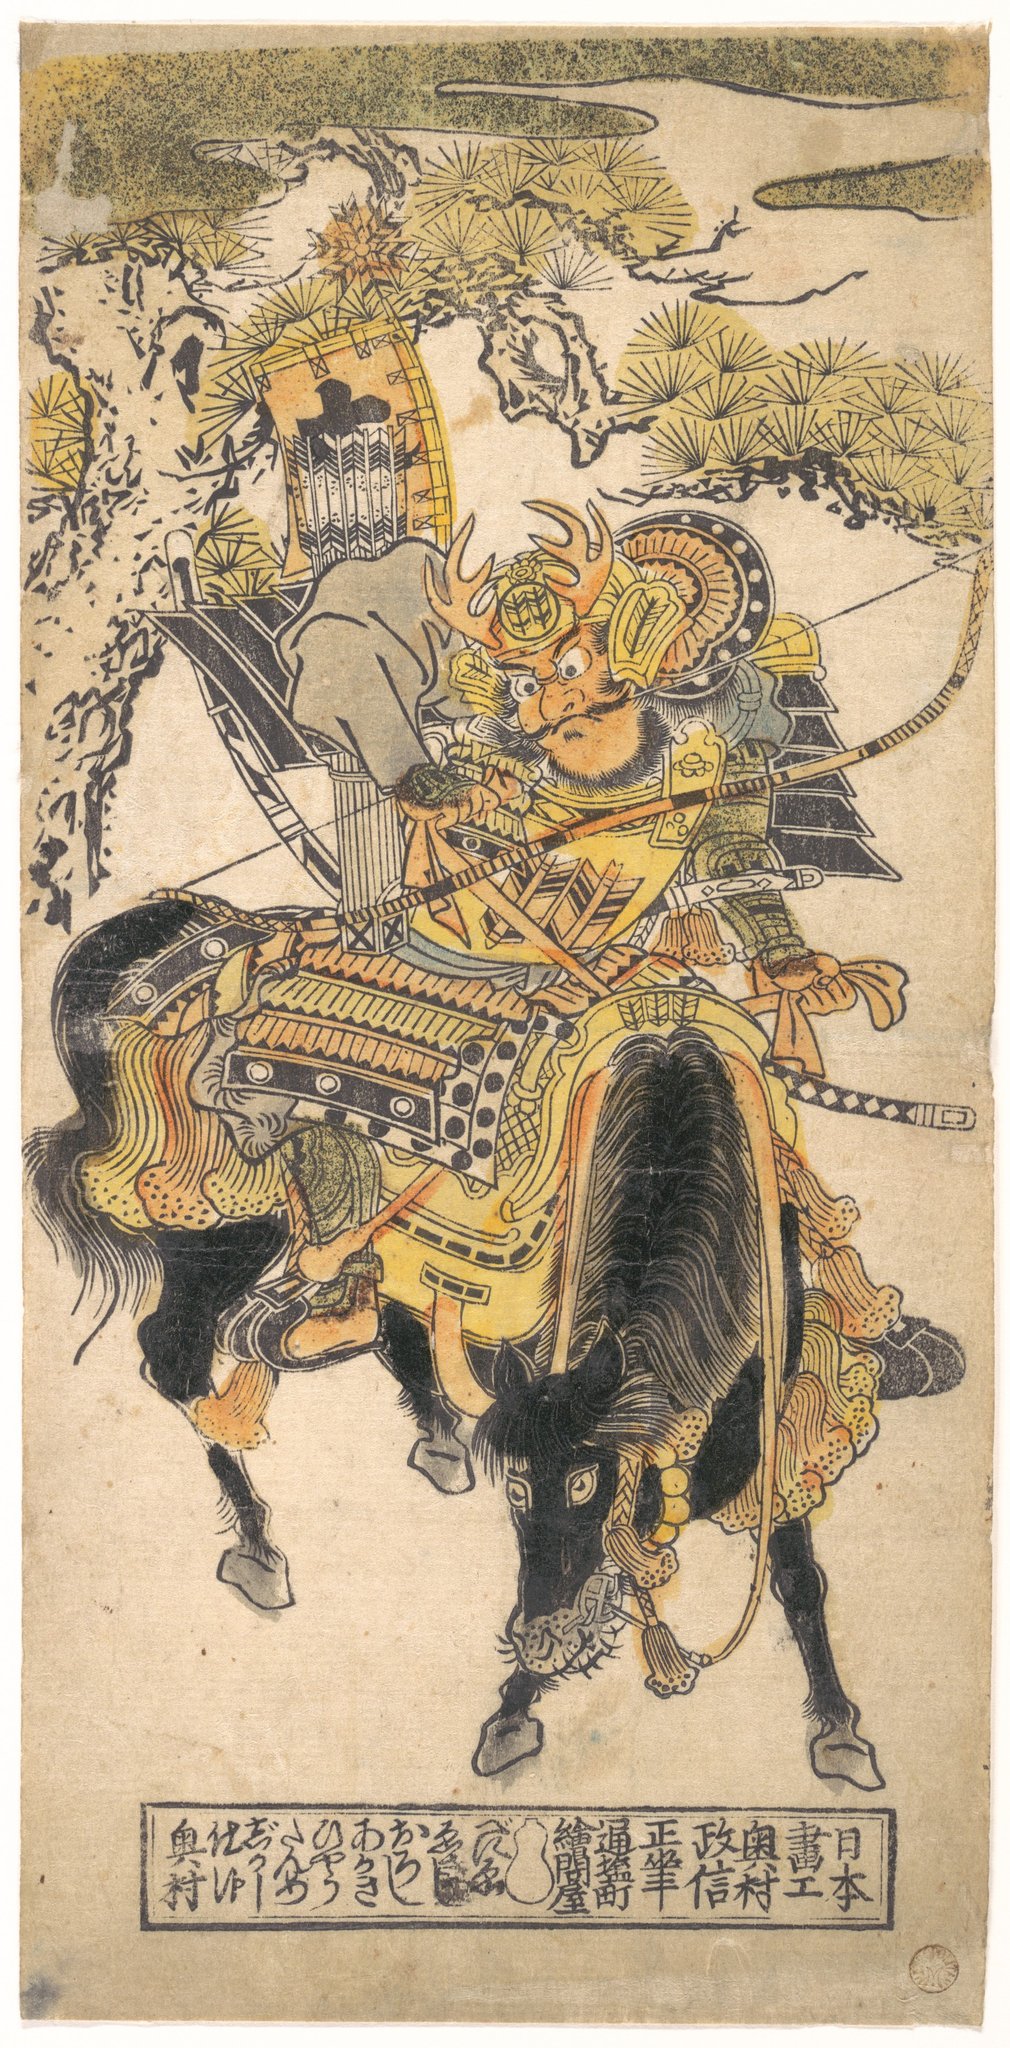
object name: lacquer print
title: The Actor Nakamuro Tomijuro as a Mounted Warrior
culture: japanese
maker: okumura masanobu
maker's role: artist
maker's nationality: japanese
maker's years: 1686-1764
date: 1740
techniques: urushi, woodblock print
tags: human figures,horses,actors